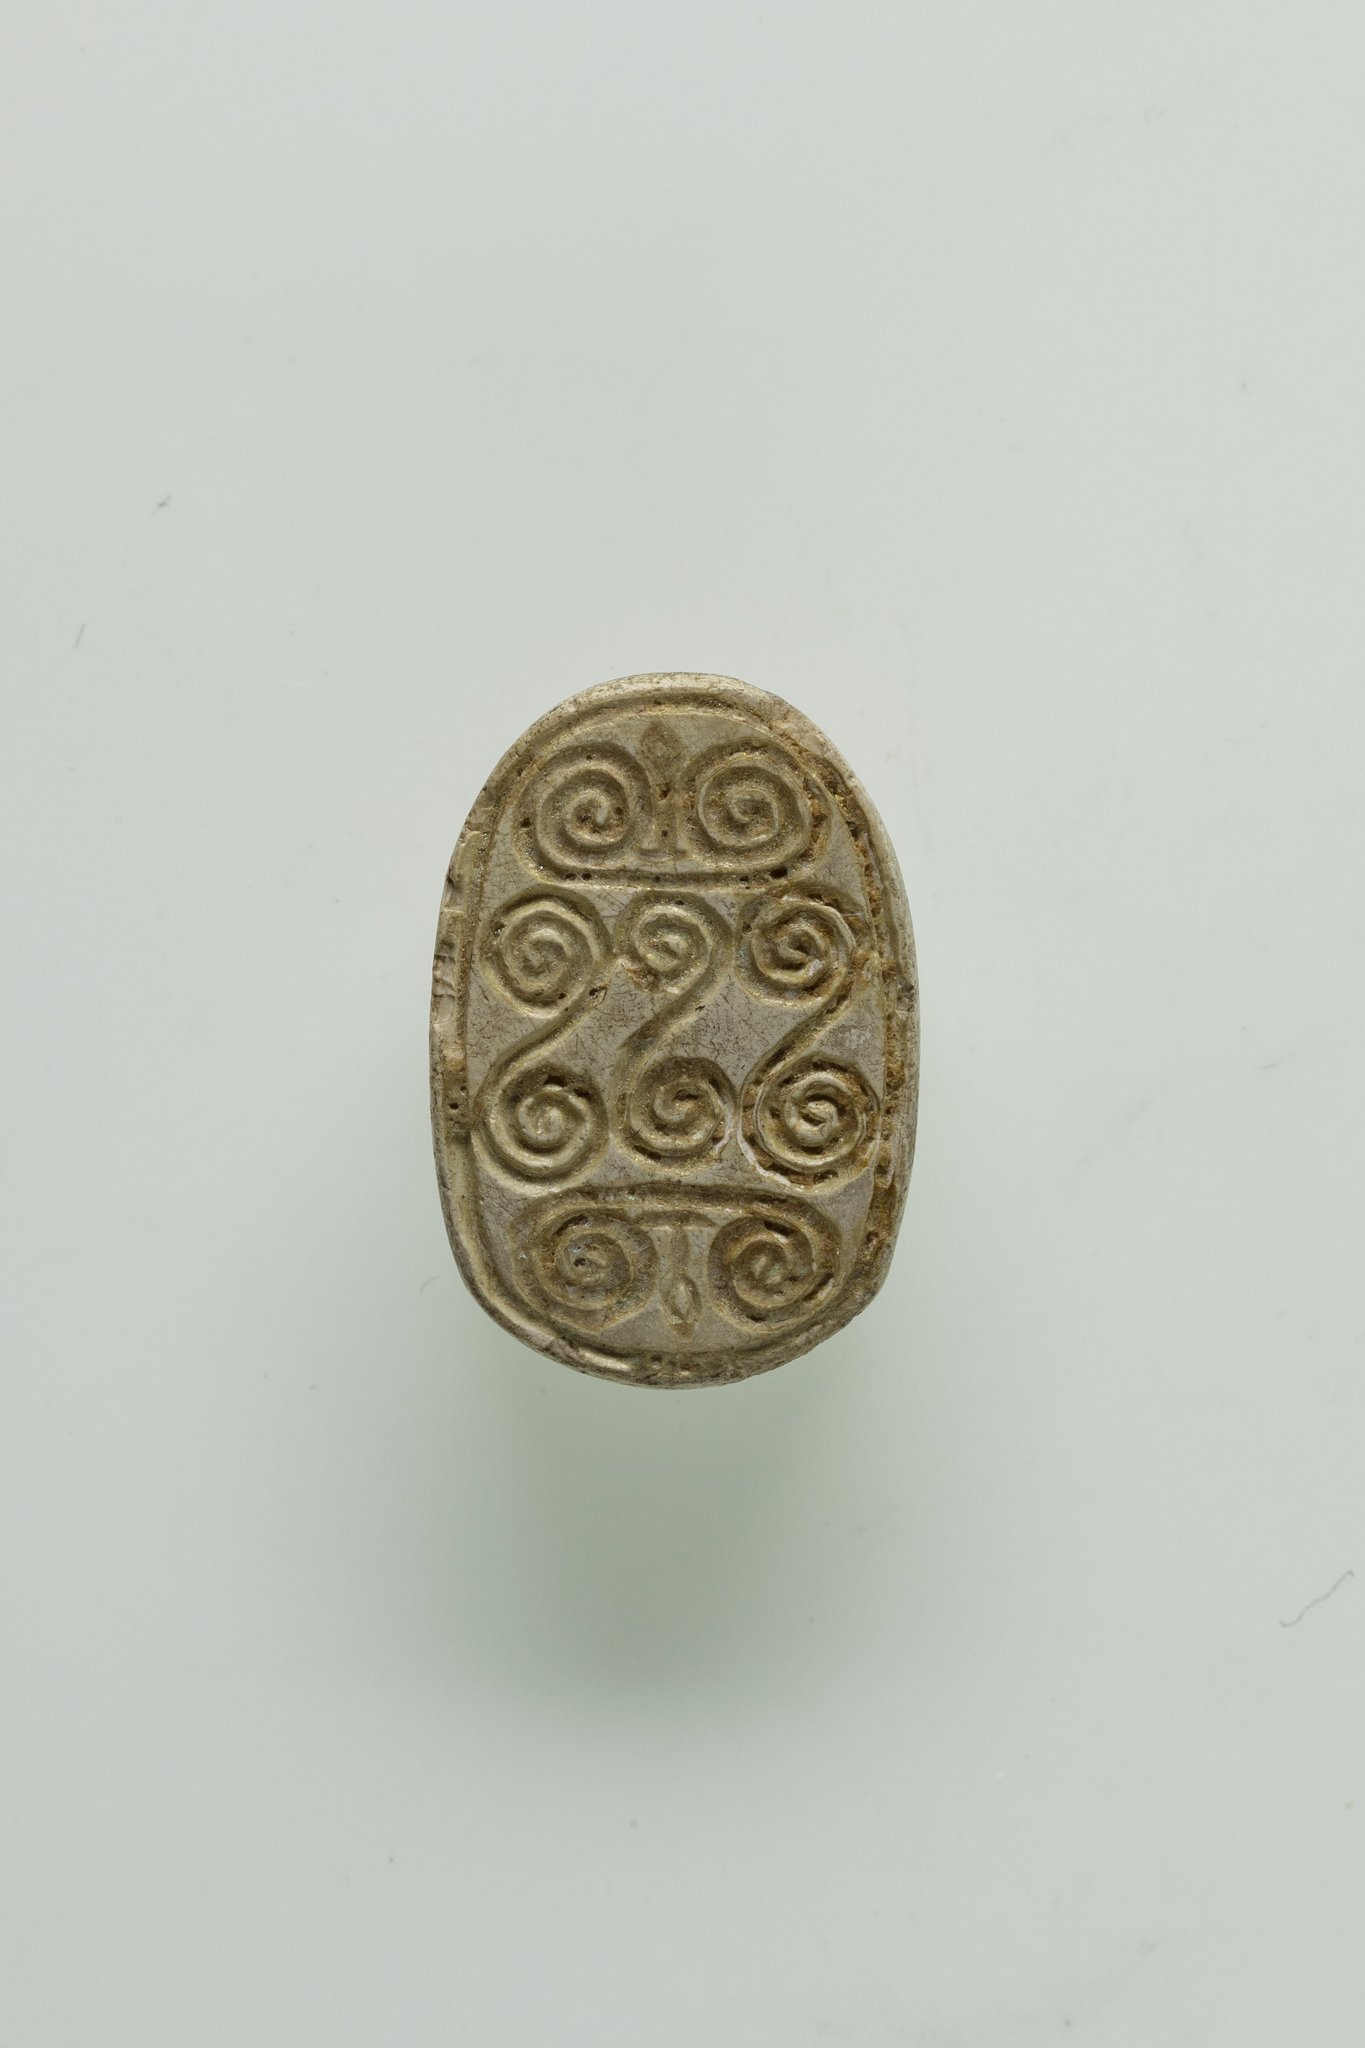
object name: scarab, nefer, scroll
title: Scarab Incised with Hieroglyphs and Scrolls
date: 1850-1640 BCE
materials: stone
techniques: glazing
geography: egypt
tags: scarabs